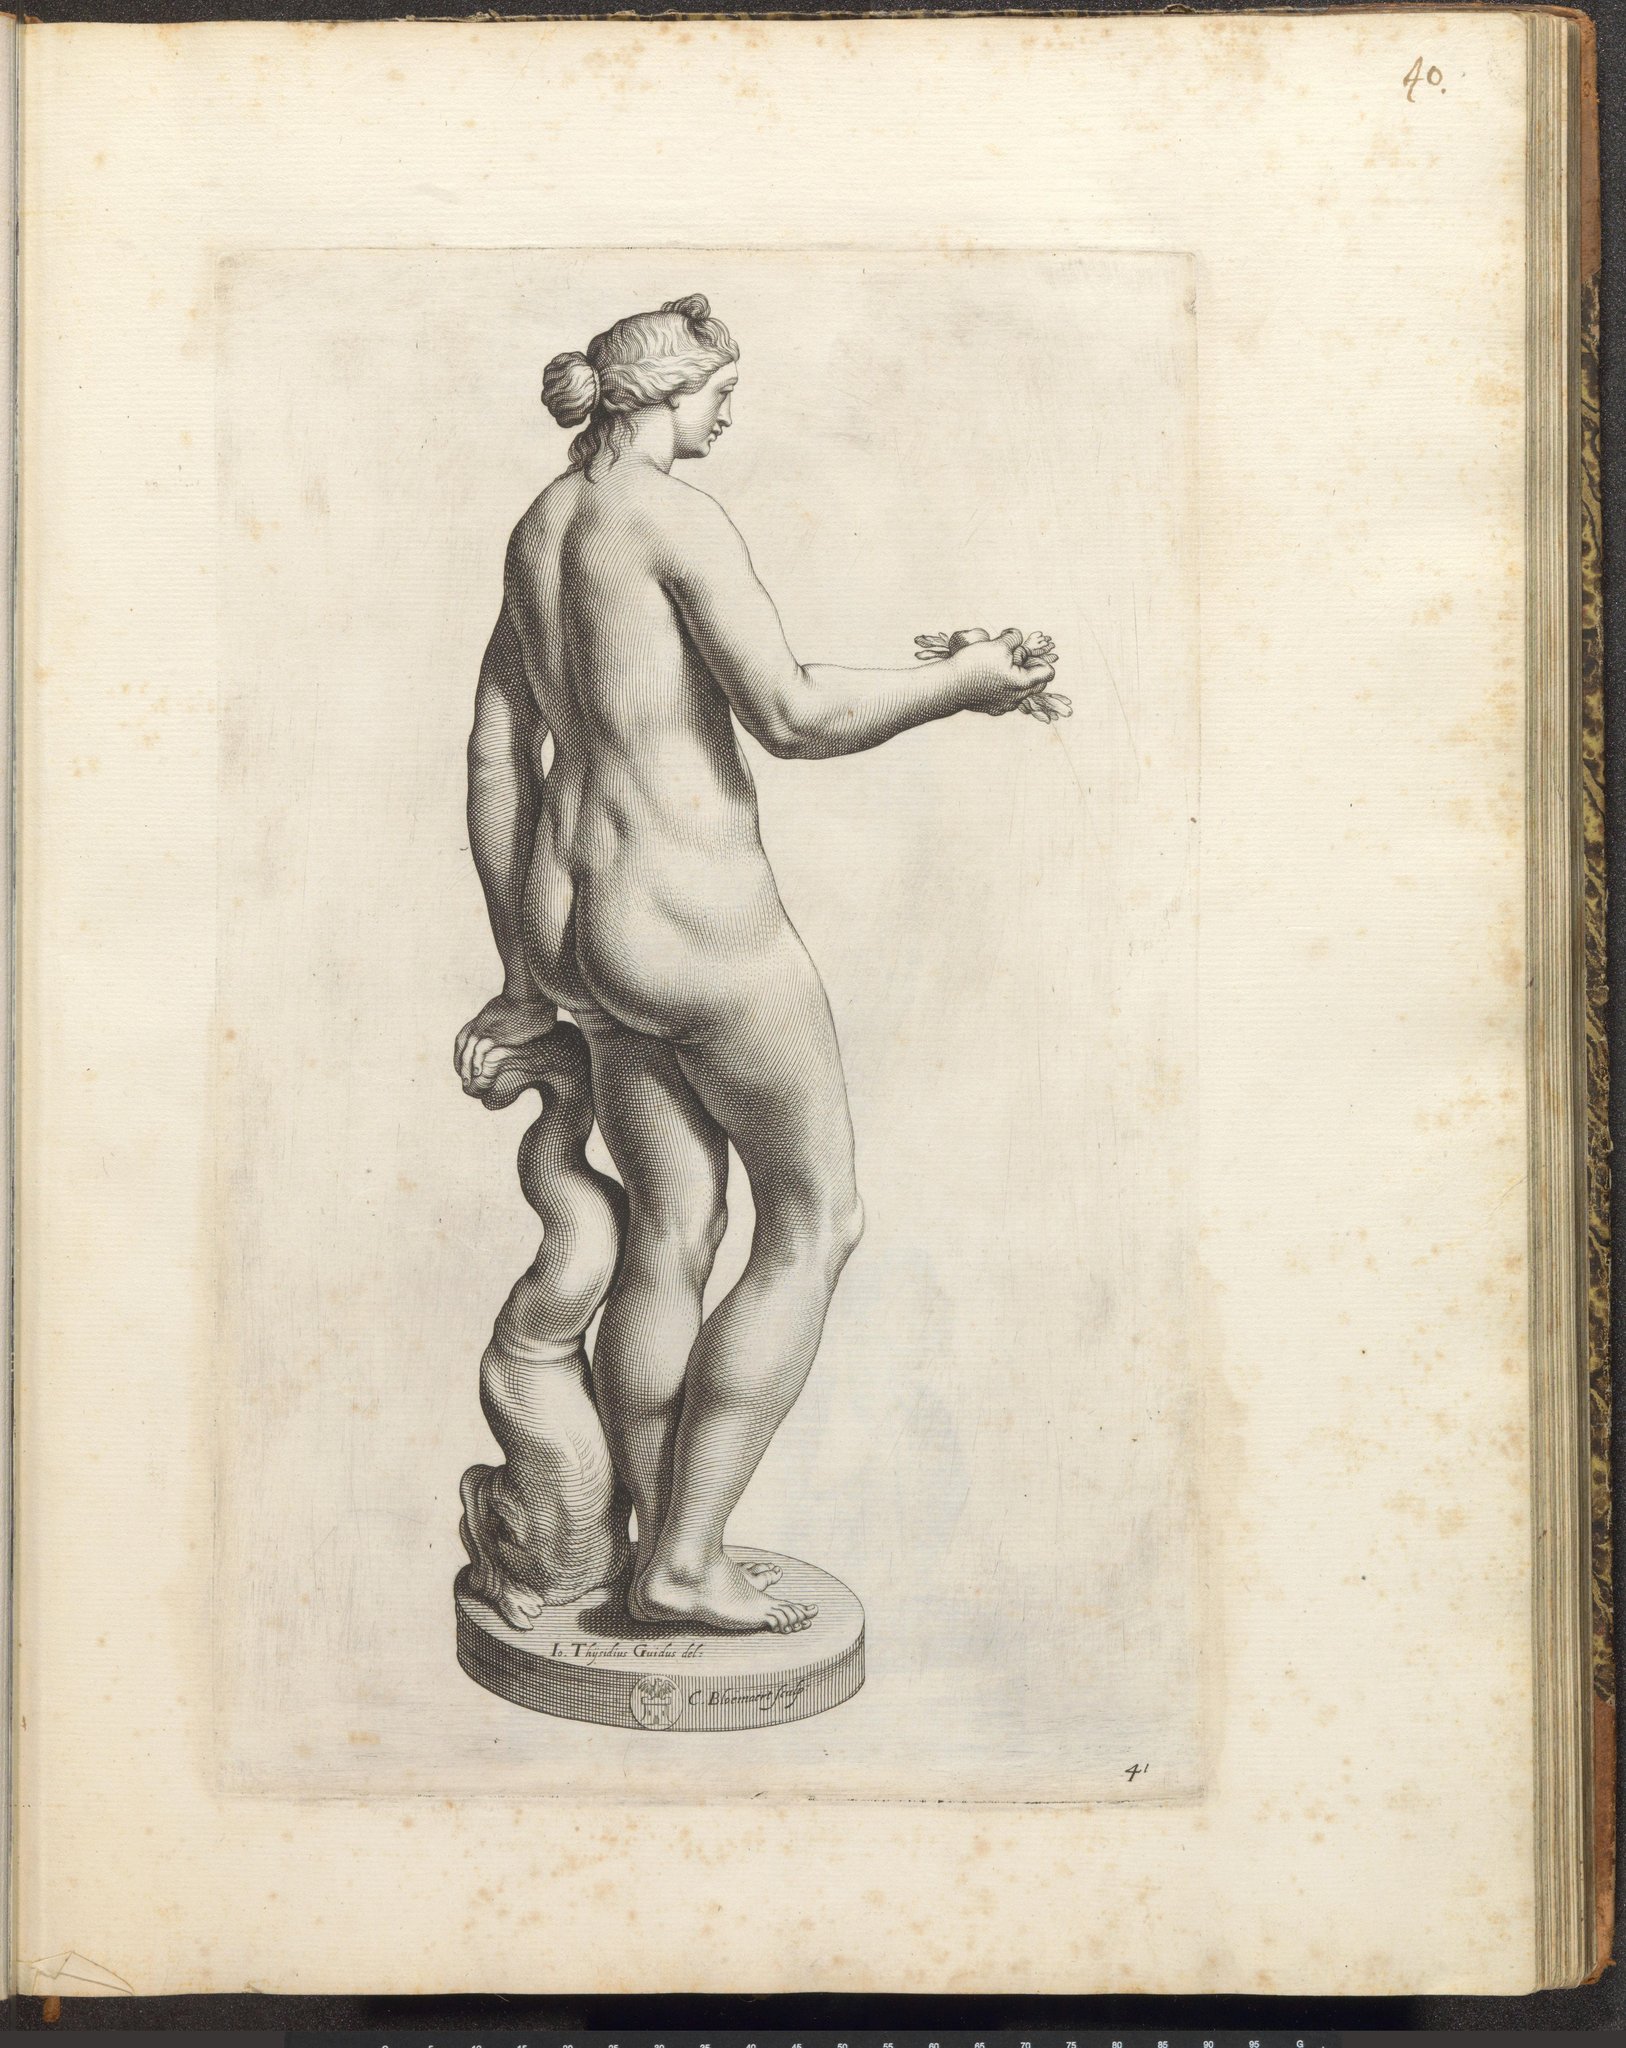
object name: print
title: Galleria Giustiniana del Marchese Vincenzo Giustiniani I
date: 1636-1647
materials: paper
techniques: engraving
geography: rome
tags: piece of sculpture, reproduction of a piece of sculpture, (story of) venus (aphrodite)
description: Beeld van Venus, de godin van de liefde, naakt, op de rug gezien. In haar rechterhand houdt ze vruchten en bladeren. Op de basis het wapenschild van Vincenzo Giustiniani. Prent maakt deel uit van een album met een serie prenten naar de sculpturen in de verzameling in de Galleria Giustiniani te Rome.